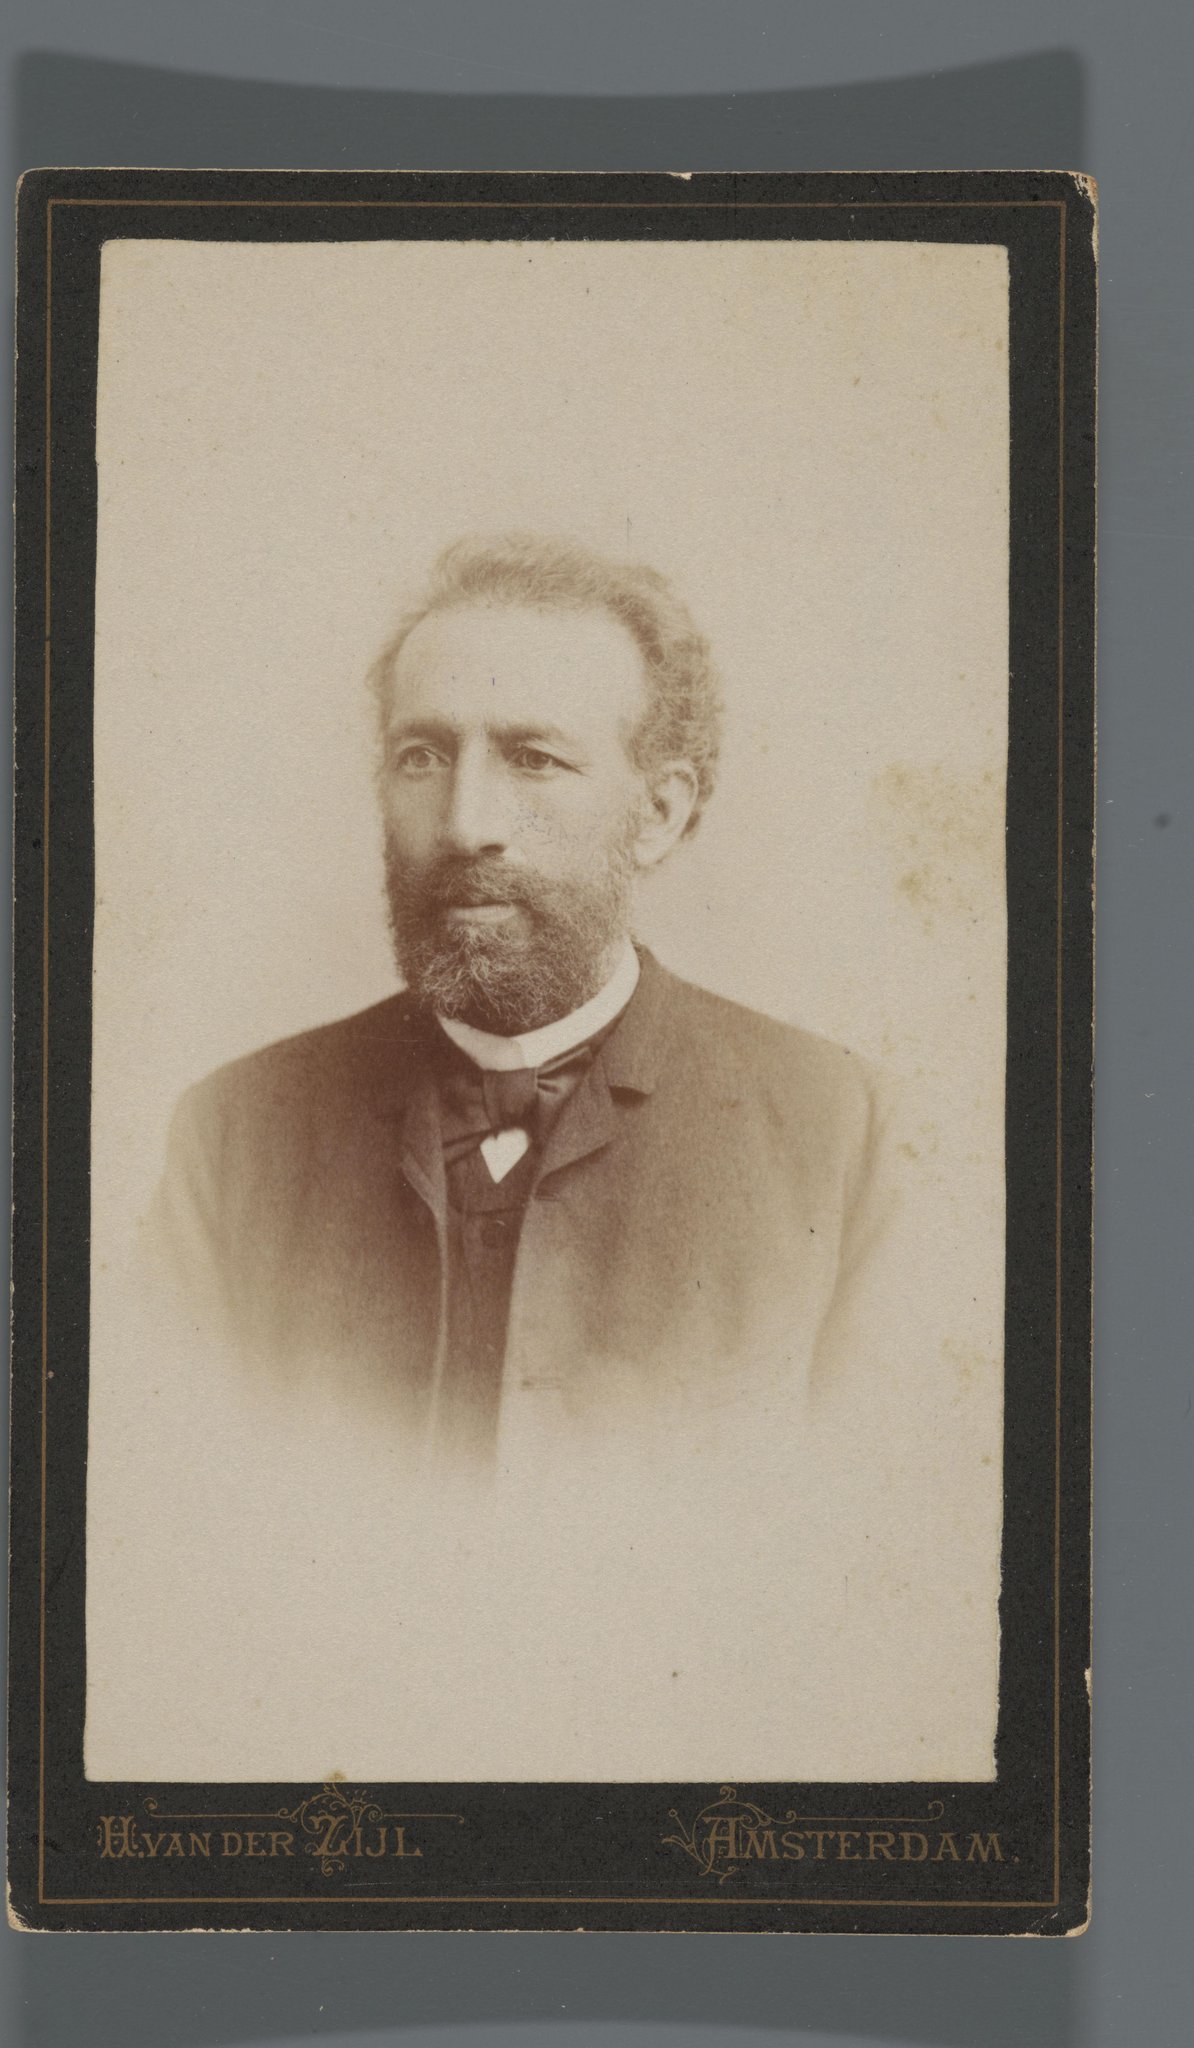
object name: carte de visite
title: Portret van een man uit de familie Marmelstein, vermoedelijk de vader van A. F. Marmelstein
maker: h. van der zijl jr.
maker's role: fotograaf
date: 1850-1900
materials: cardboard, photographic support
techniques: albumen print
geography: amsterdam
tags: adult man, historical persons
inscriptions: retailer's mark: ‘Photographie/ Parisienne/ (...)’